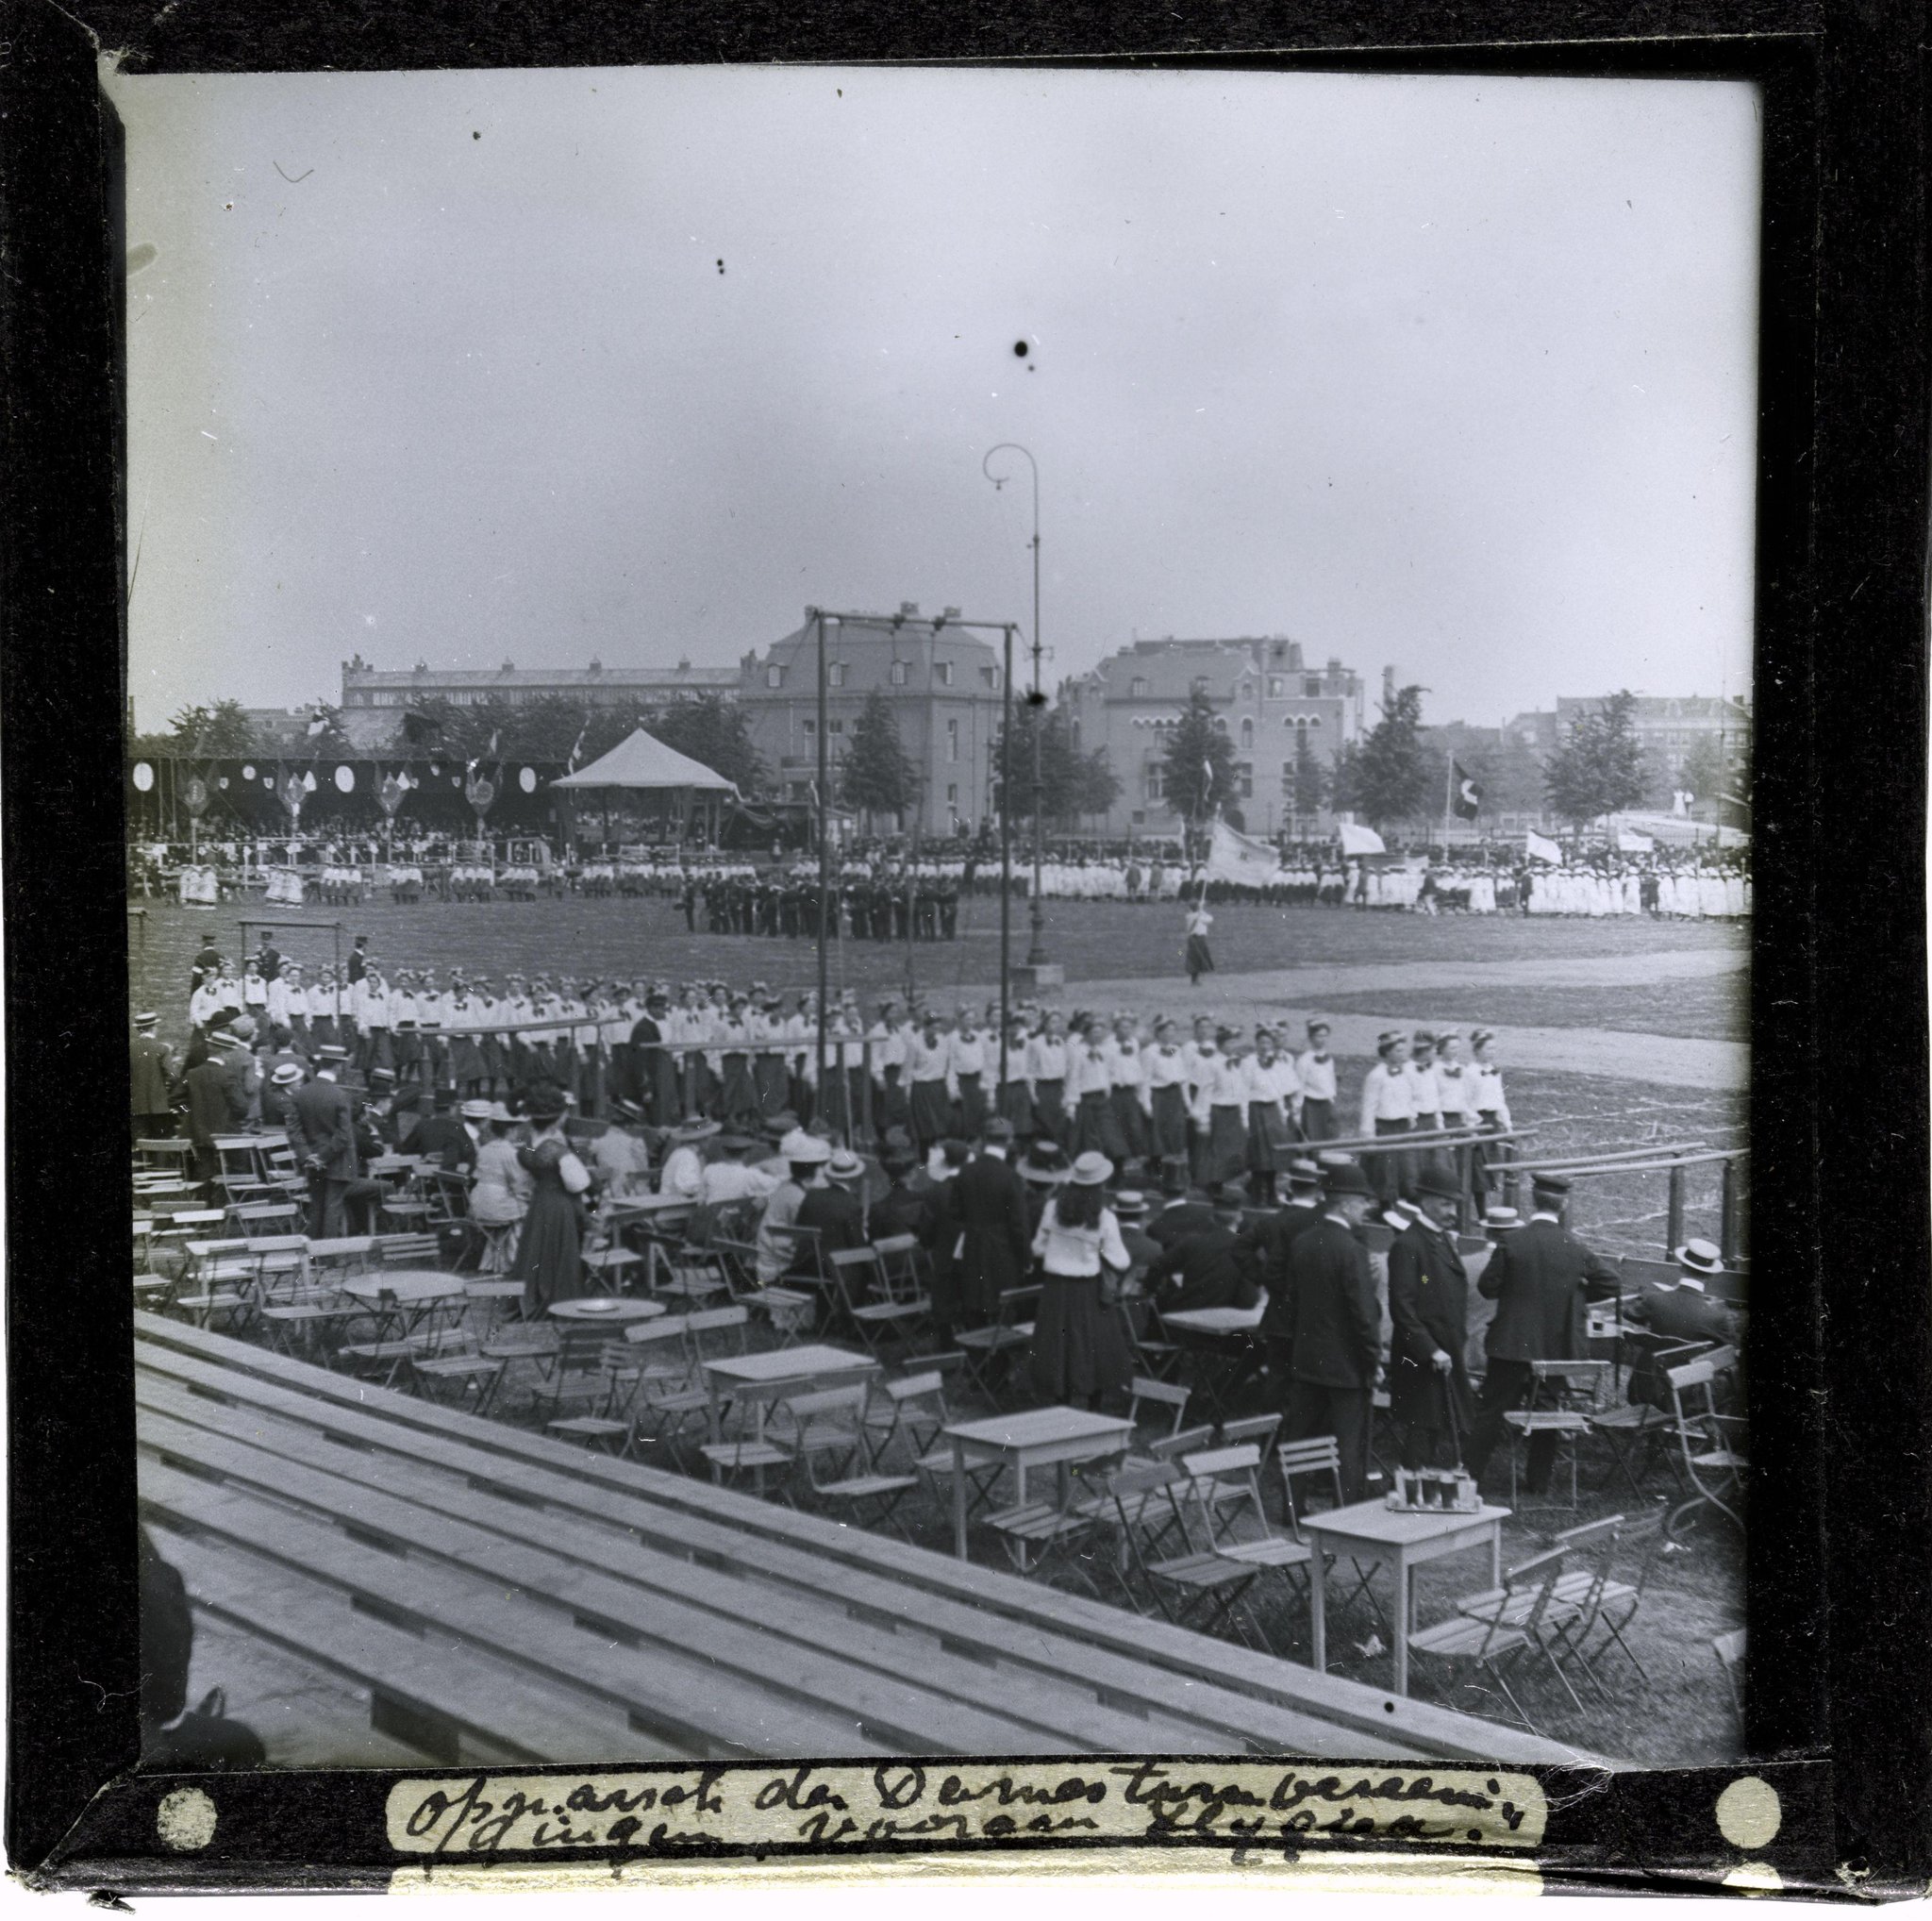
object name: photograph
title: [...]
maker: Anonymous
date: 1907-1935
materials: glass, ink, paper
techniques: slide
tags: sports, etc. on land, tournament